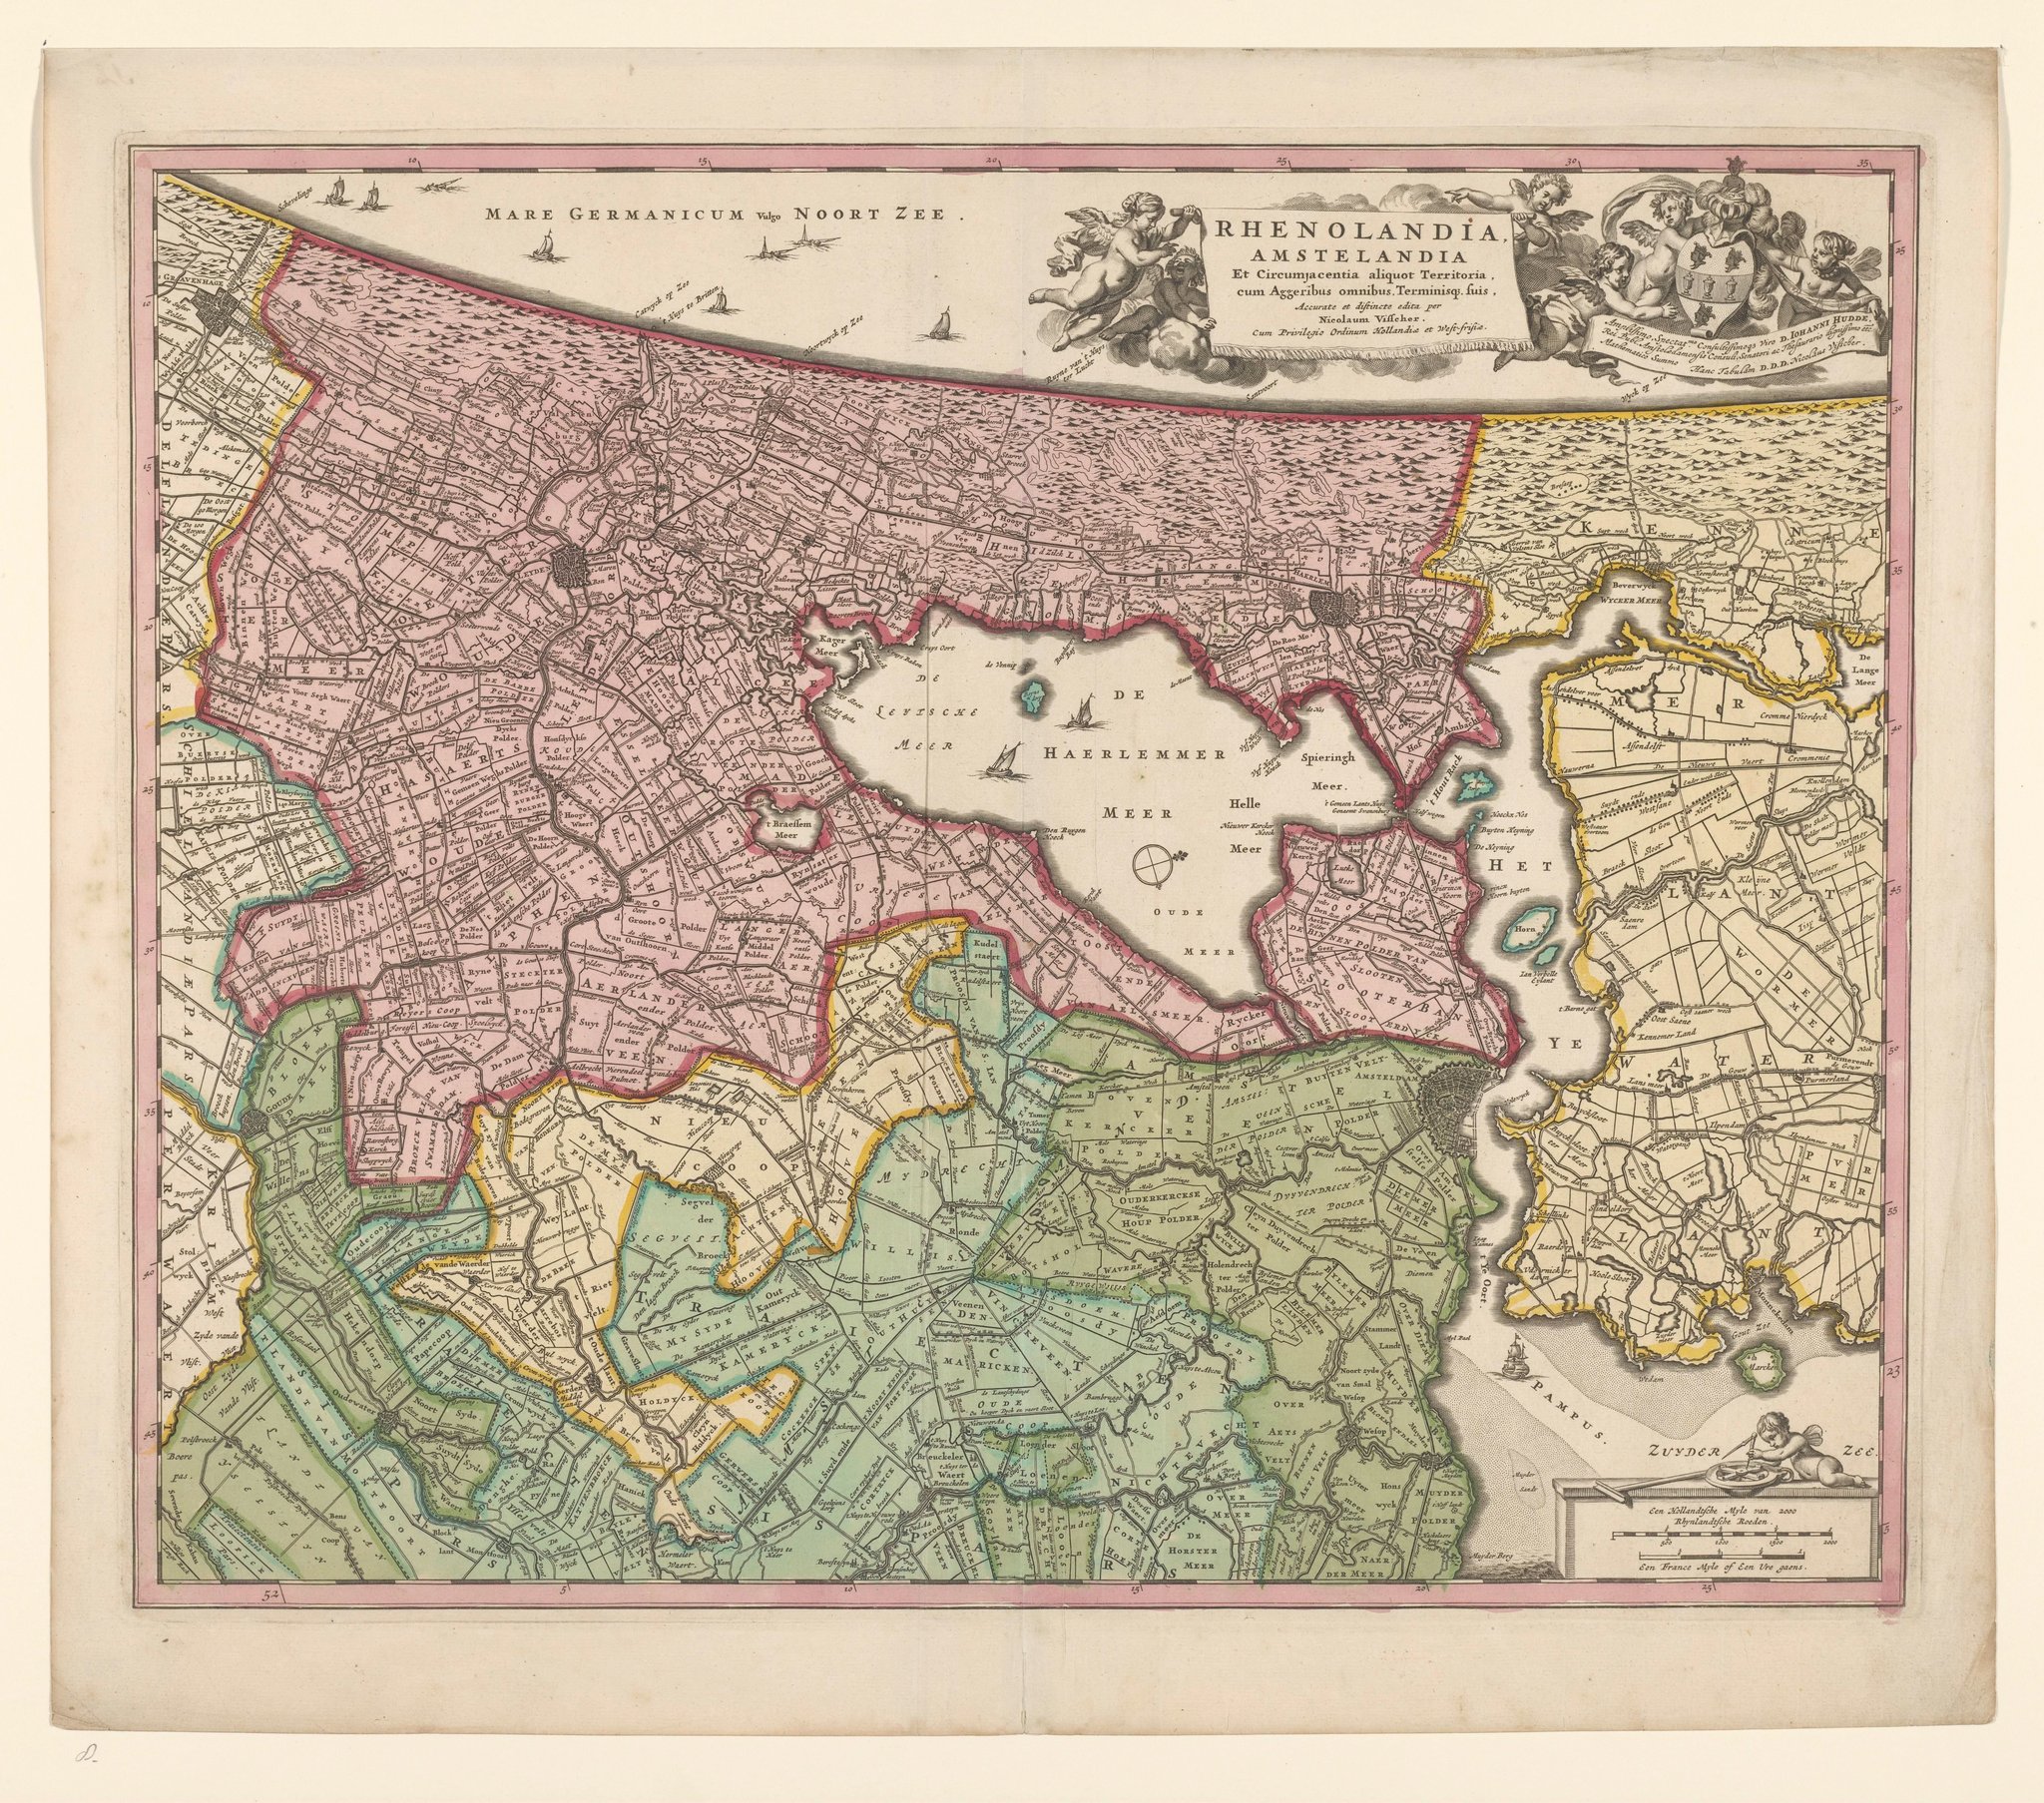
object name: map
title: Kaart van Rijnland en Amstelland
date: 1675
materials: paper, watercolor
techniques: engraving, hand coloring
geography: amsterdam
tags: johannes hudde, maps of separate countries or regions, armorial bearing, heraldry, rhineland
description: Kaart van Rijnland en Amstelland met het westen boven. Rechtsboven de titel op een kleed gedragen door putti, daarnaast rechts utti met wapenschild en helm boven opdracht aan Johannes Hudde. rrechtsonder schaal in Hollandse en Franse mijlen, daar vlak boven een putto met attributen van de cartograaf (1:180.000).